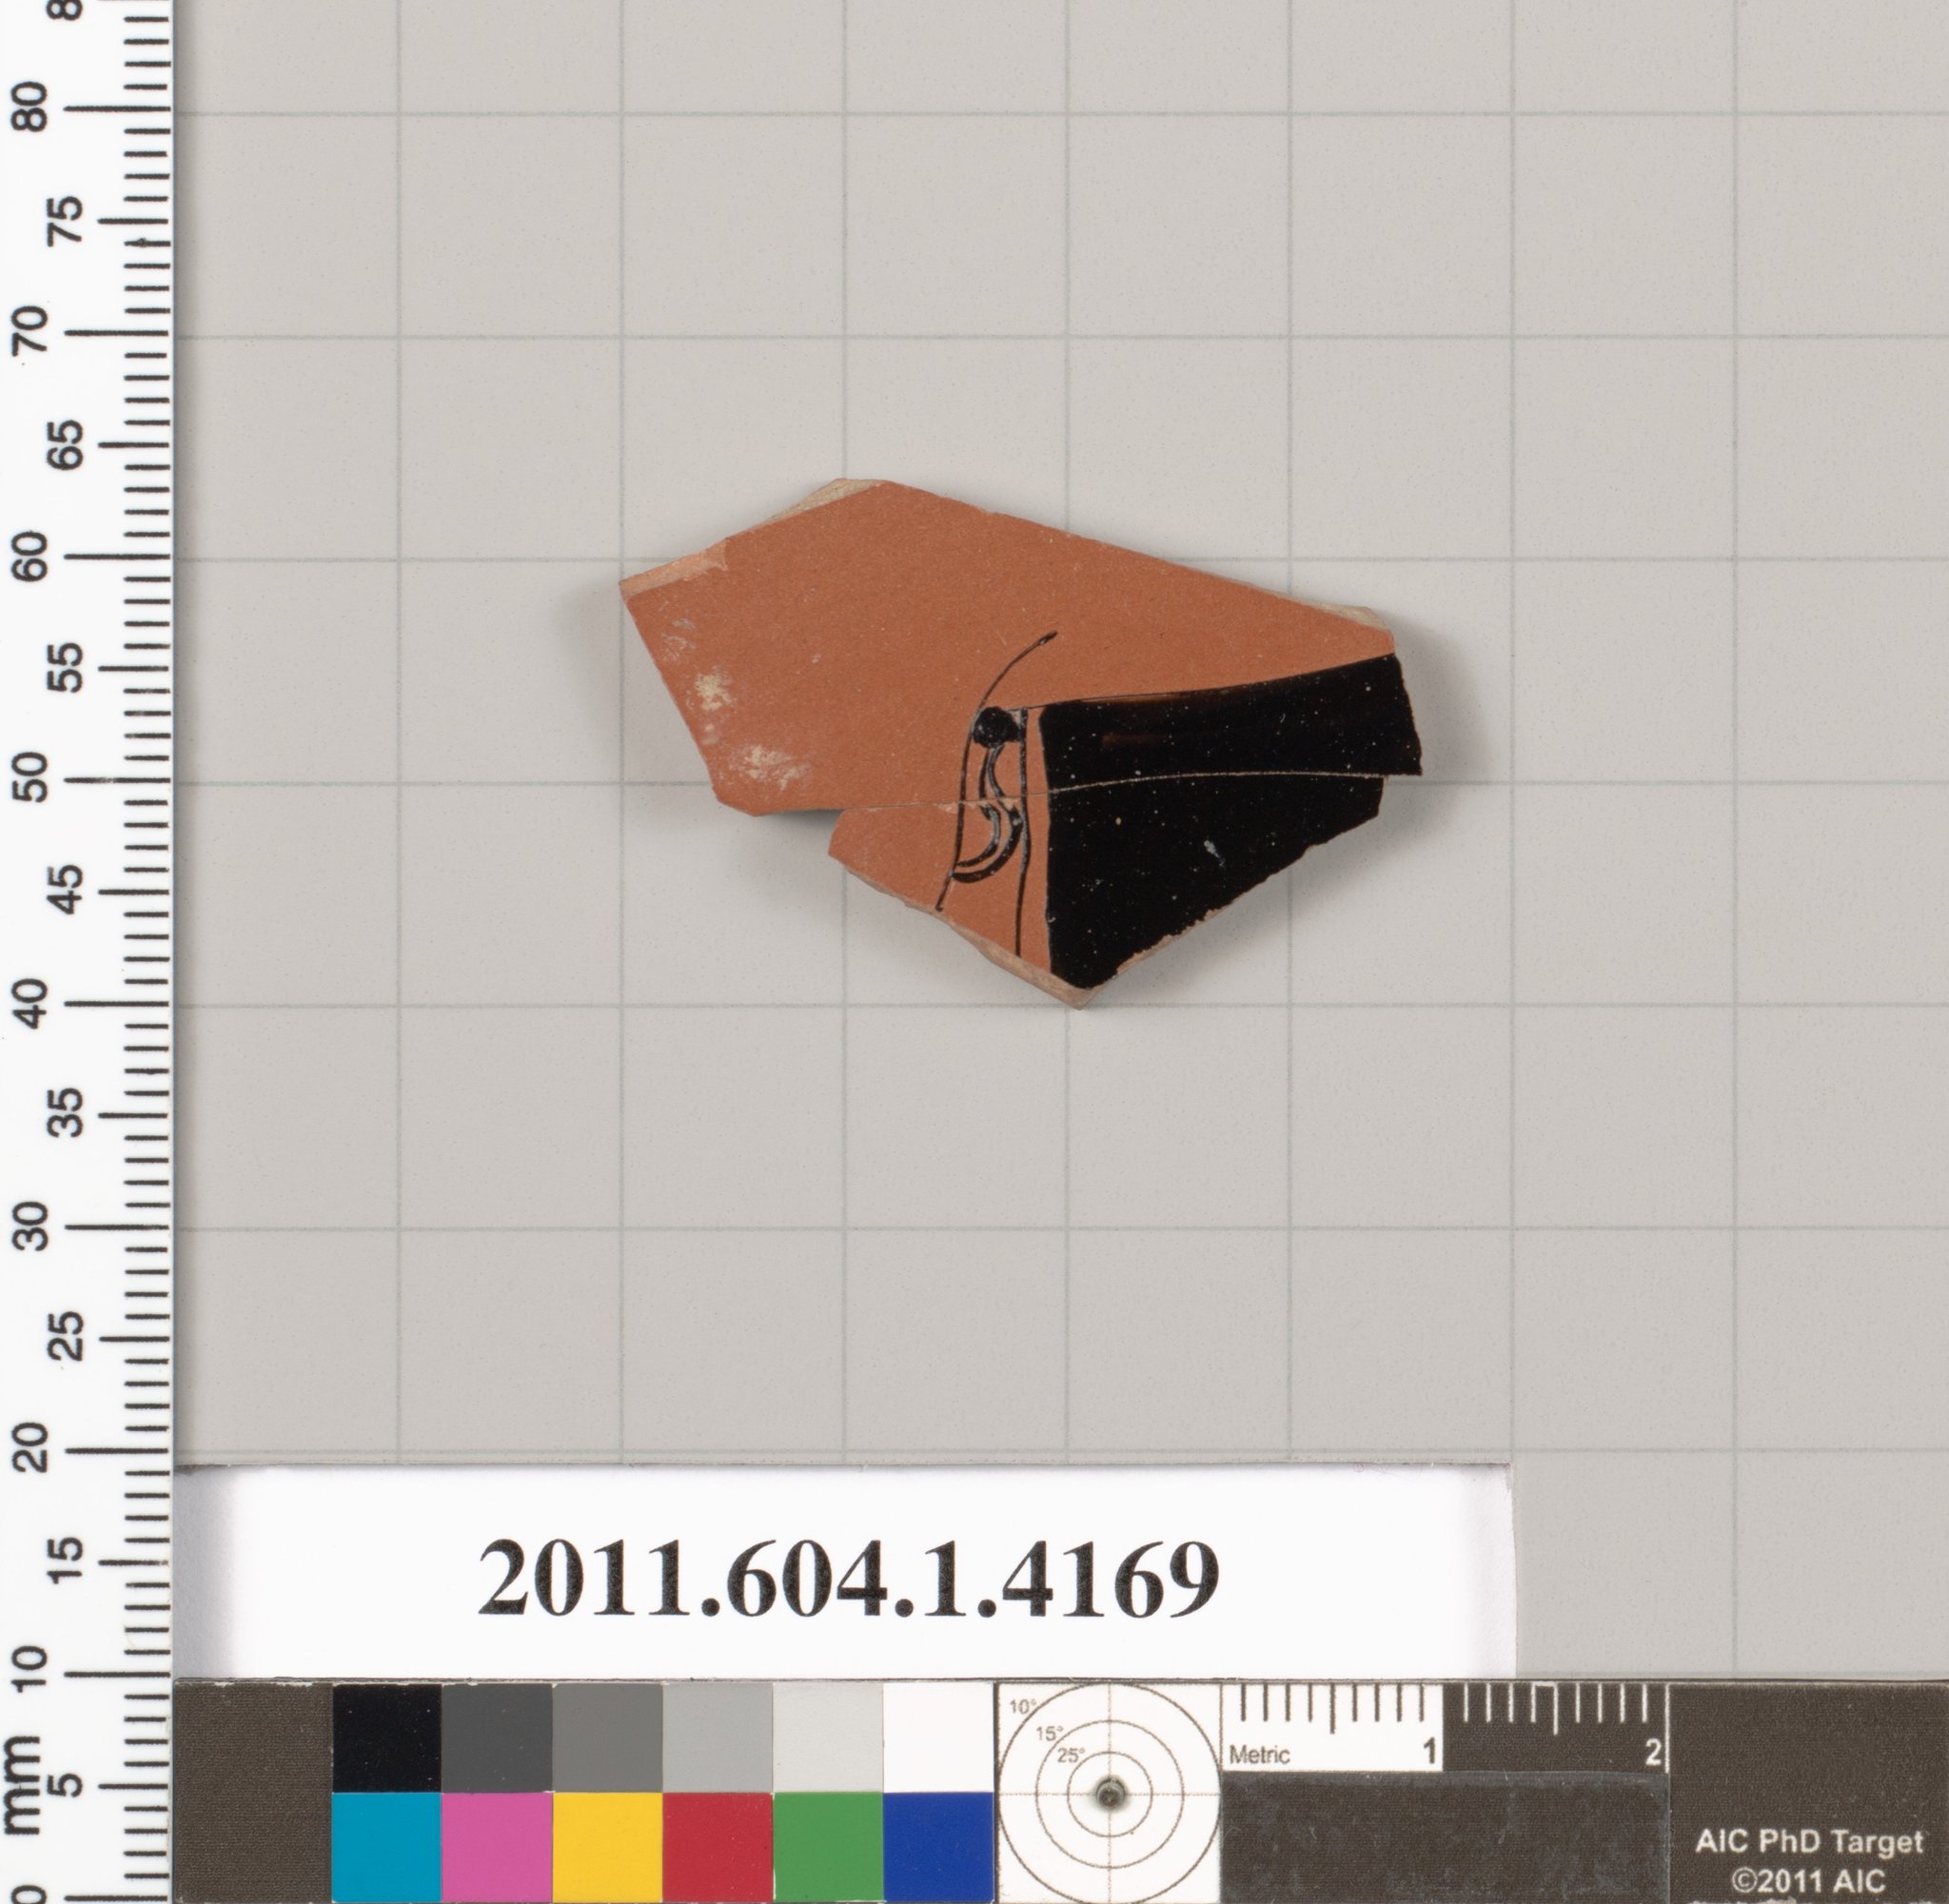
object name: kylix fragment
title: Terracotta fragment of a kylix (drinking cup)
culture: greek, attic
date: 500-480 BCE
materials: terracotta